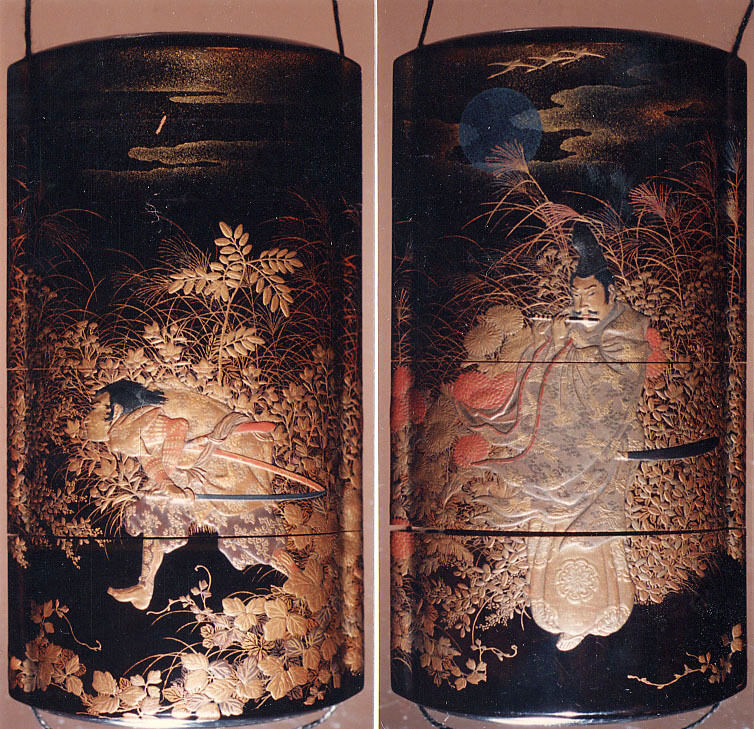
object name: inrō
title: Case (Inrō) with Design of the Courtier Yasusuke Playing Flute beneath Full Moon (obverse); His Brother Kidomaru Hiding among Autumn Grasses (reverse)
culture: japanese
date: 1615-1868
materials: gold, lacquer, silver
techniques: fundame, hiramakie, roiro, maki-e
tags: men,flutes,flowers